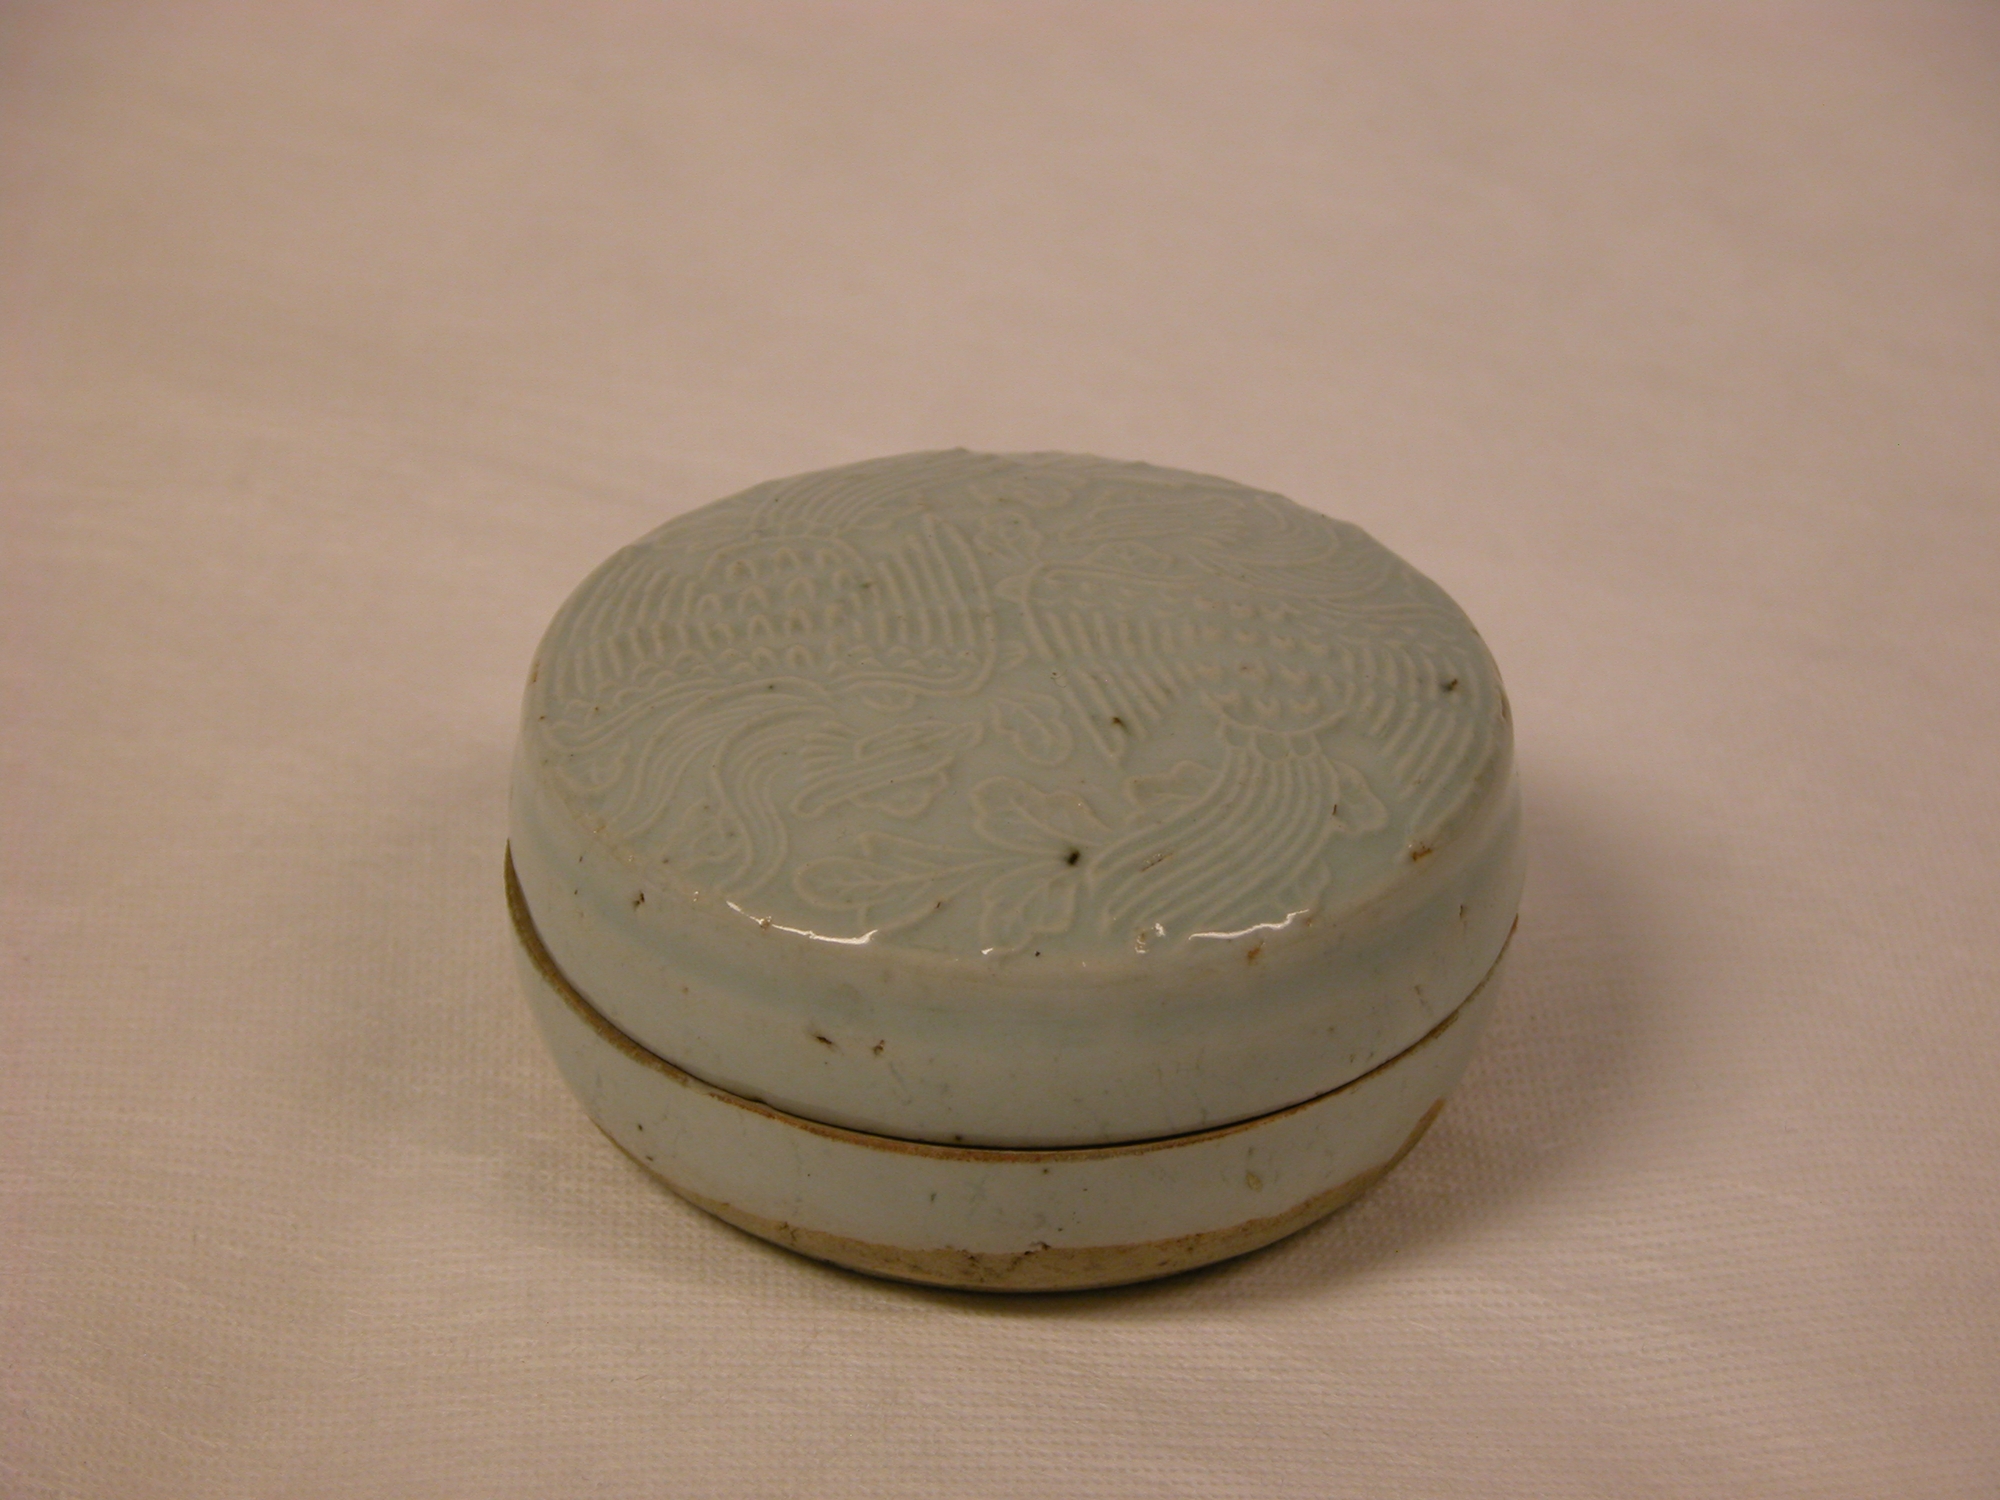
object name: box with cover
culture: chinese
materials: porcelain